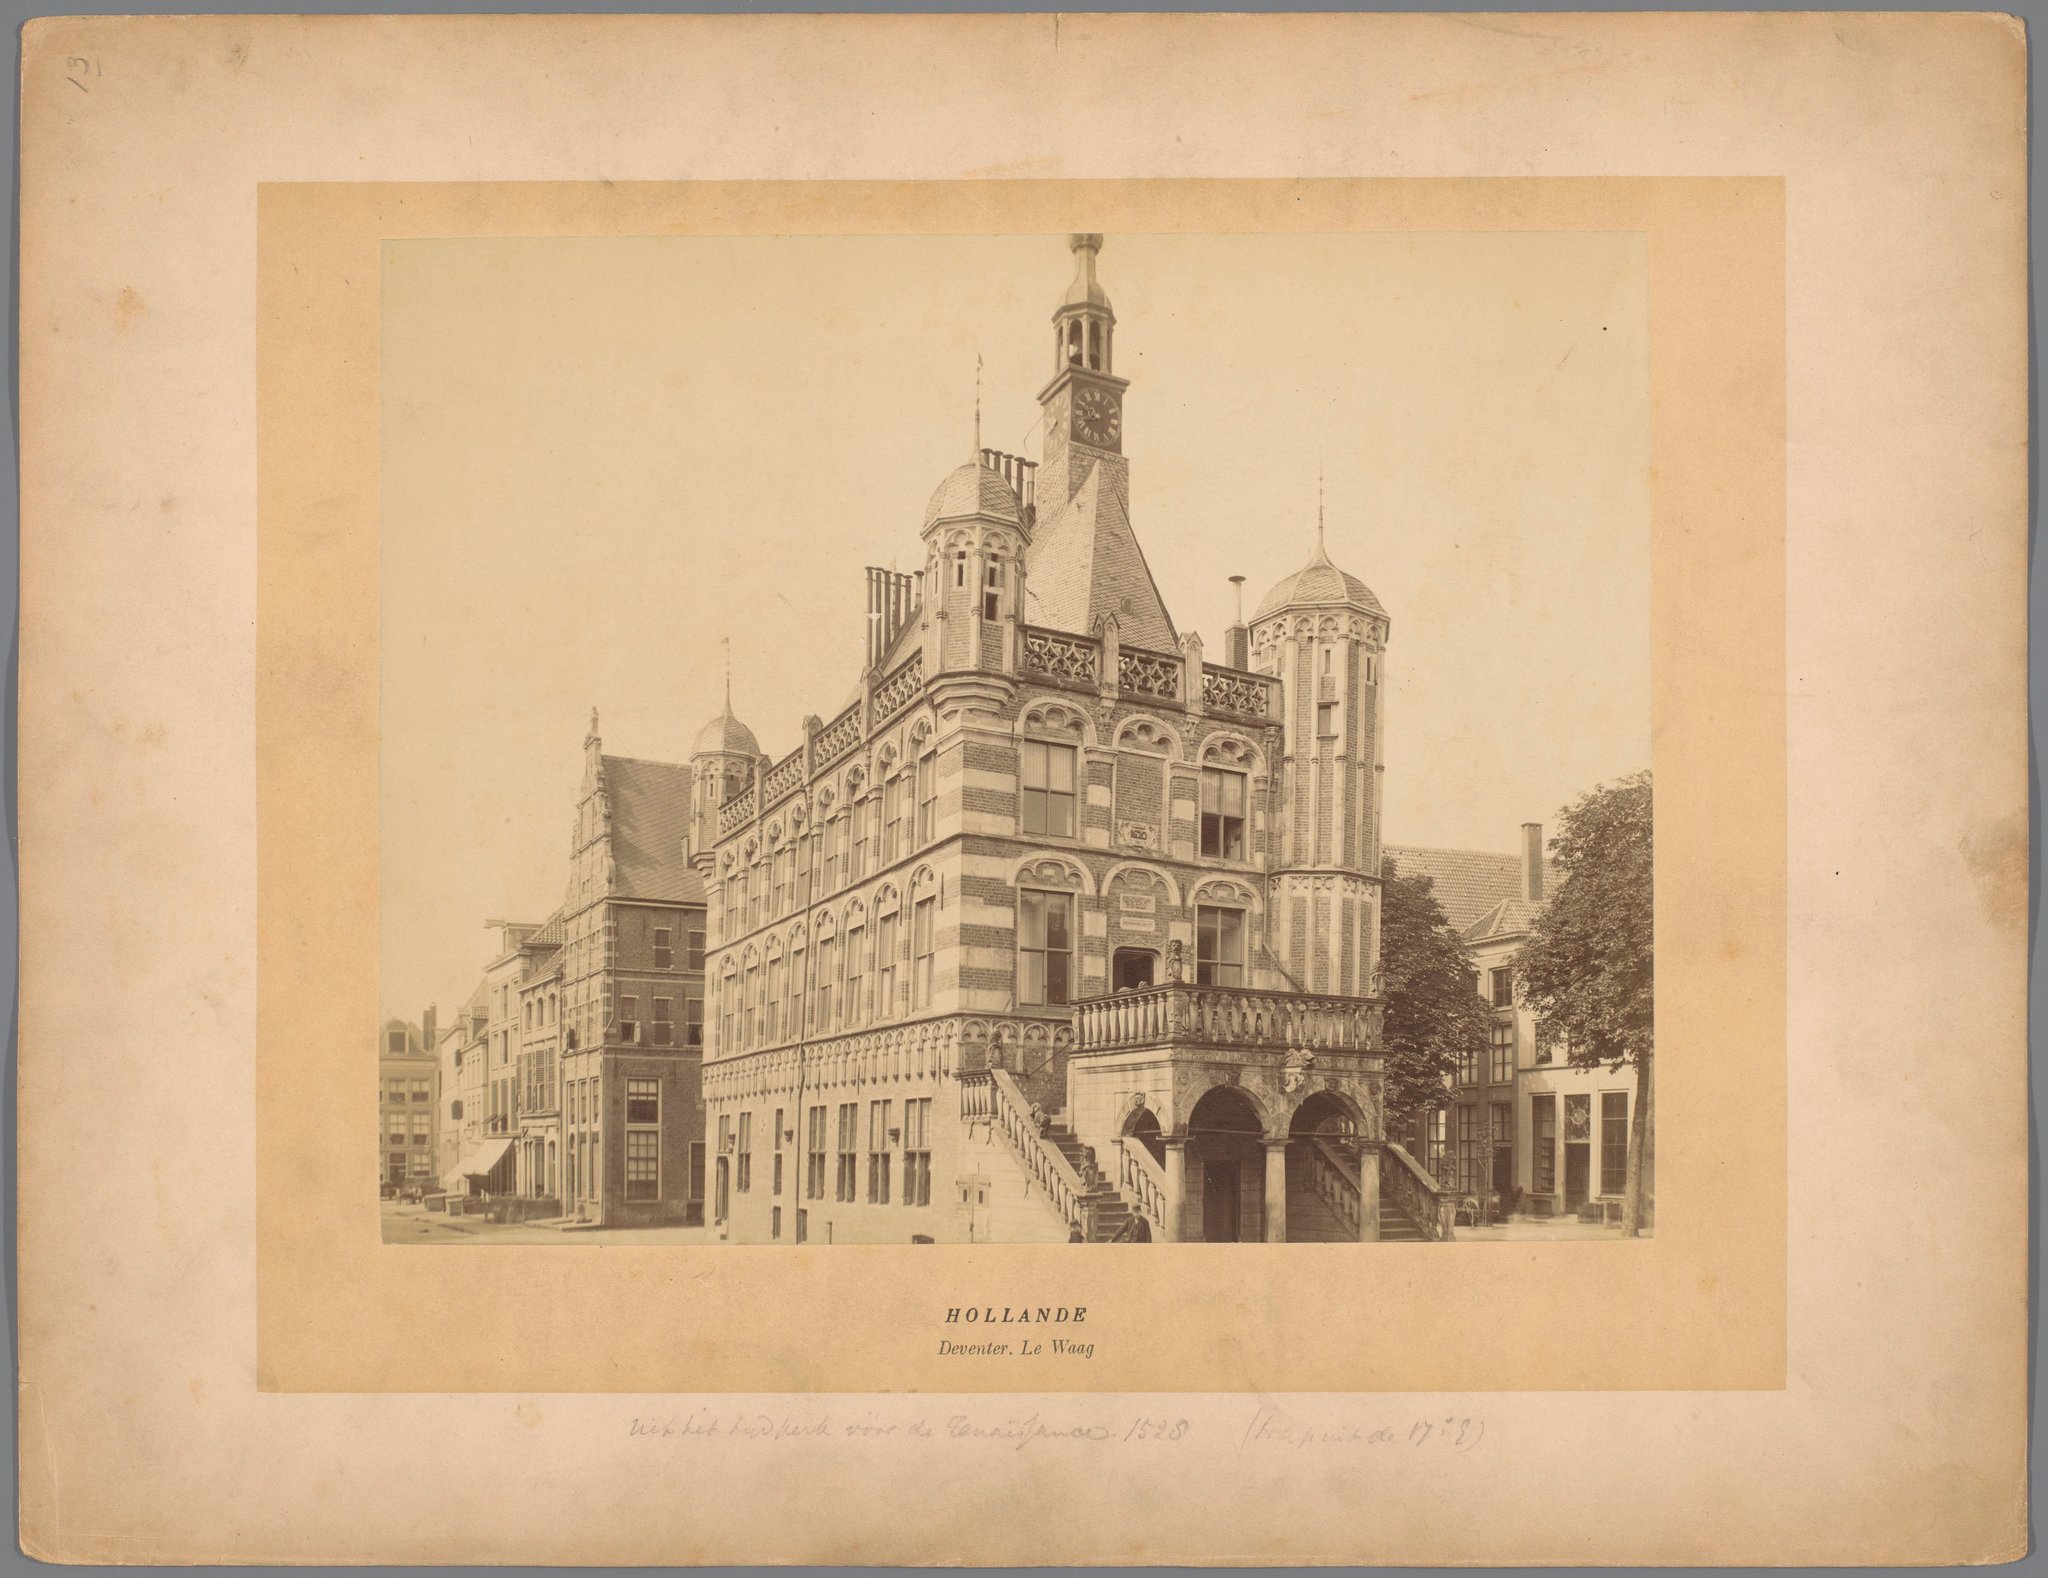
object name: photograph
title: Exterieur van de Waag te Deventer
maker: Anonymous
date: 1875-1900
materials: cardboard, photographic support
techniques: albumen print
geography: deventer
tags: façade (of house or building), weigh-house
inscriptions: inscription: ‘HOLLANDE Deventer. Le Waag’, inscription: ‘uit het tijdperk vóór de Renaissance. 1528 (trap uit de 17e E)’, collector's mark: Lugt 3937